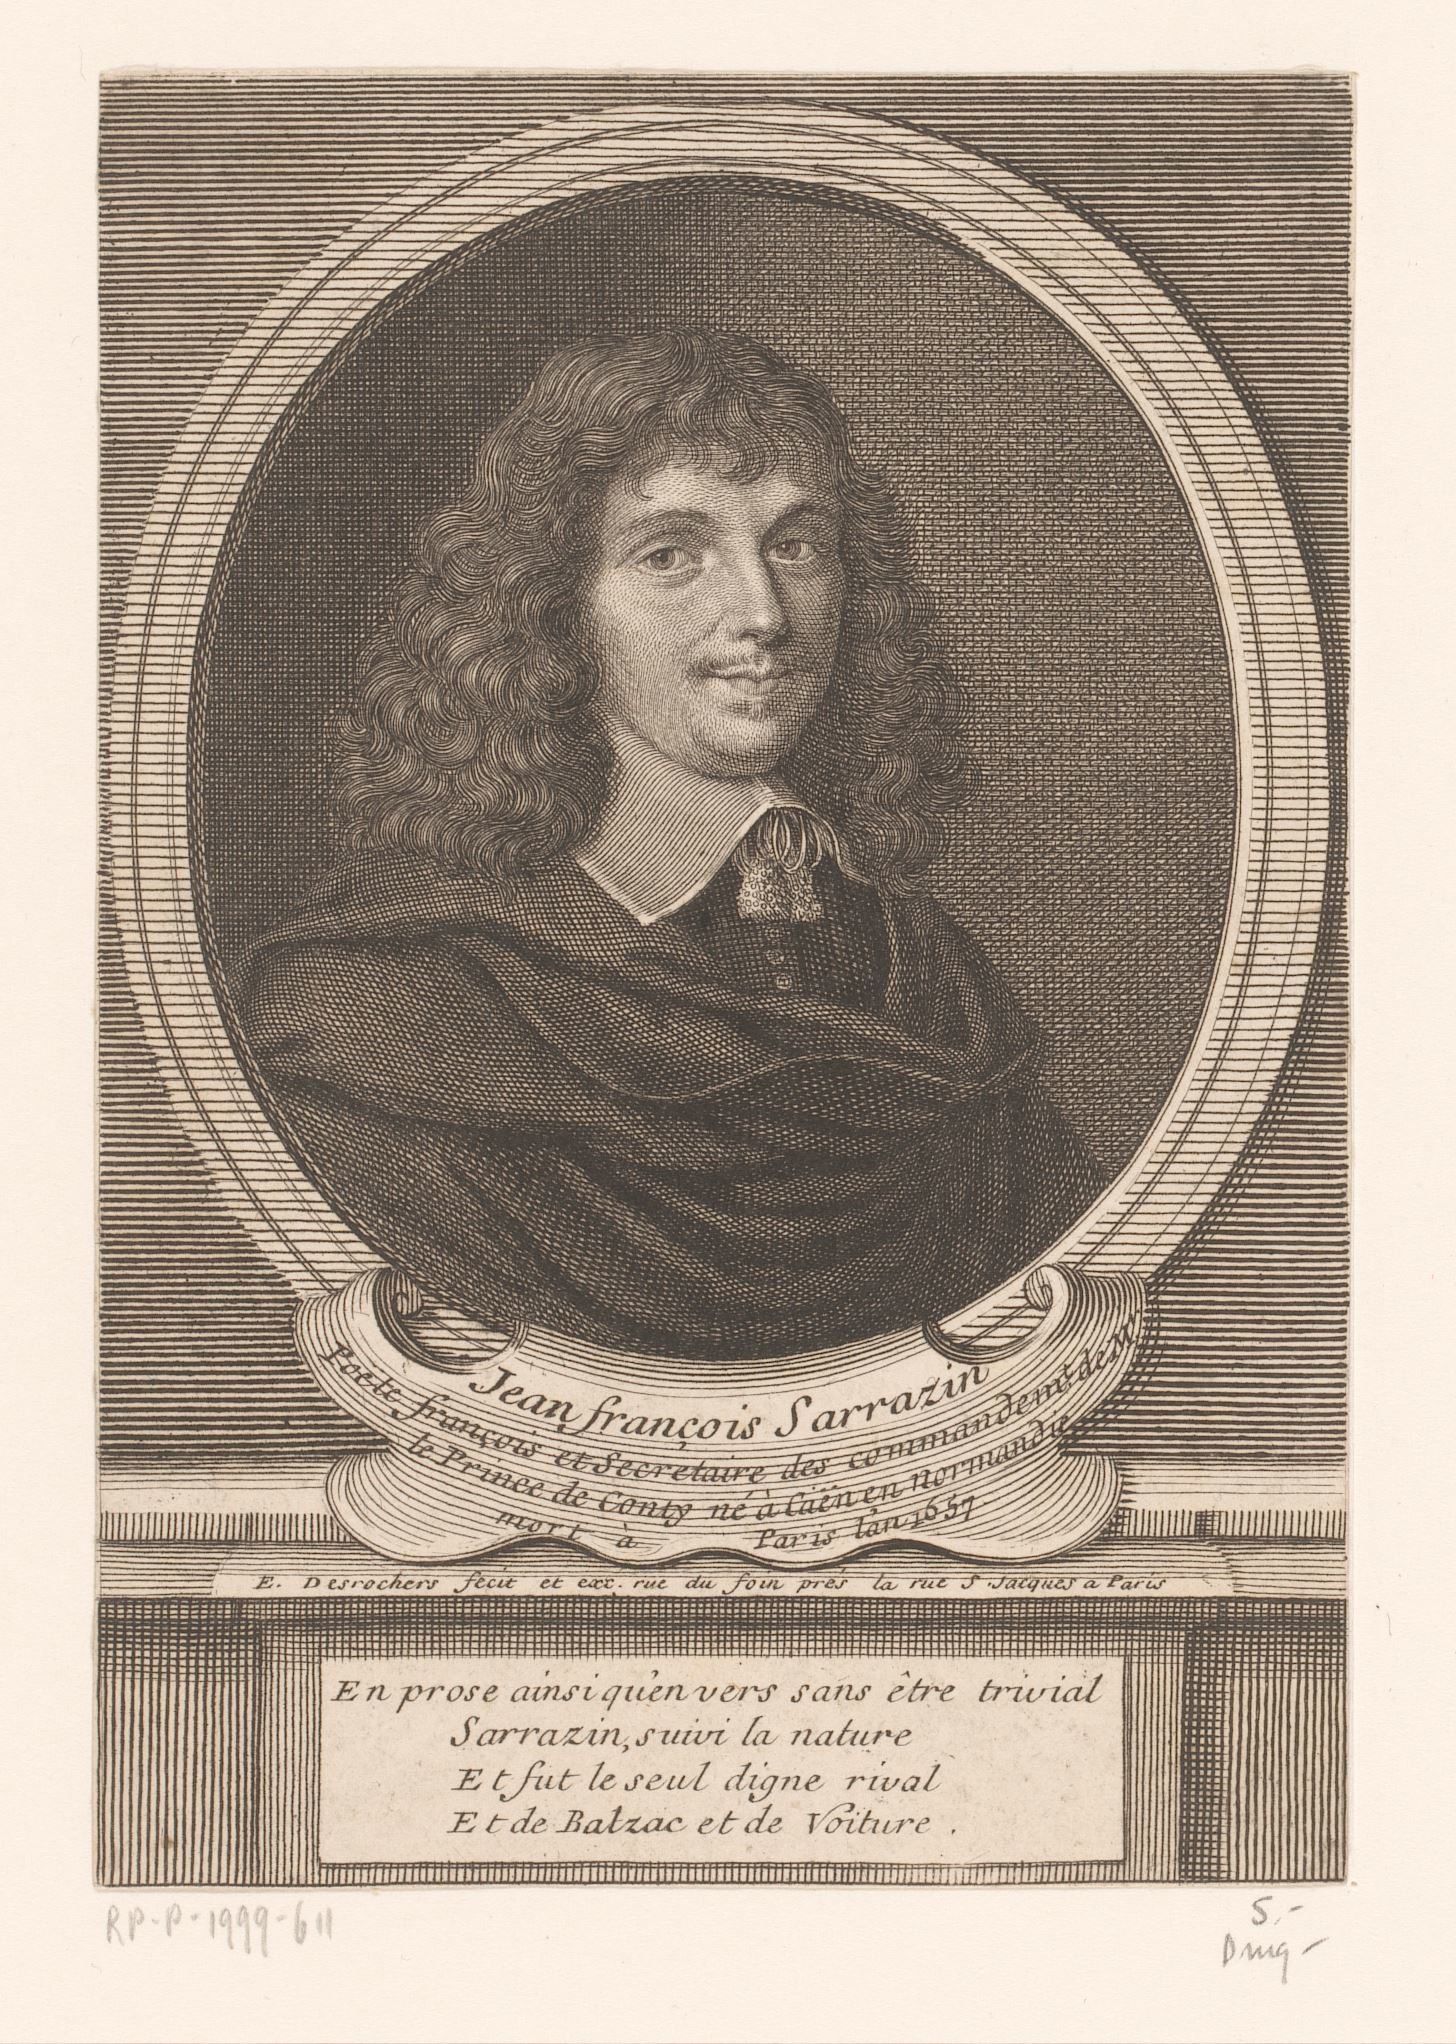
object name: print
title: Recueil de portraits (...)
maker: étienne desrochers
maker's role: print maker, publisher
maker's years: 1668-1741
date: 1726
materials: paper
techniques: engraving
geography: paris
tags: historical persons, portrait of a writer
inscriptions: collector's mark: Lugt 2228, collector's mark: Lugt 2760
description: Behoort waarschijnlijk tot een serie portretten, grotendeels door Etienne Desrochers, getiteld: 'Recueil de portraits de personnes qui se sont distinguées tant dans les Armes que dans Belles-Lettres et les Arts, comme aussi la famille royale de France et autres cours étrangères'. De serie werd initieel uitgegeven door Desrochers en aangekondigd in 'Mercure' in mei 1726, p. 985. Echter was Desrochers reeds enkele jaren eerder begonnen met het uitgeven van de serie. Na de dood van Desrochers werd de serie voortgezet door Gilles Edme Petit. Een latere staat werd uitgegeven door Jean François Daumont in Parijs.